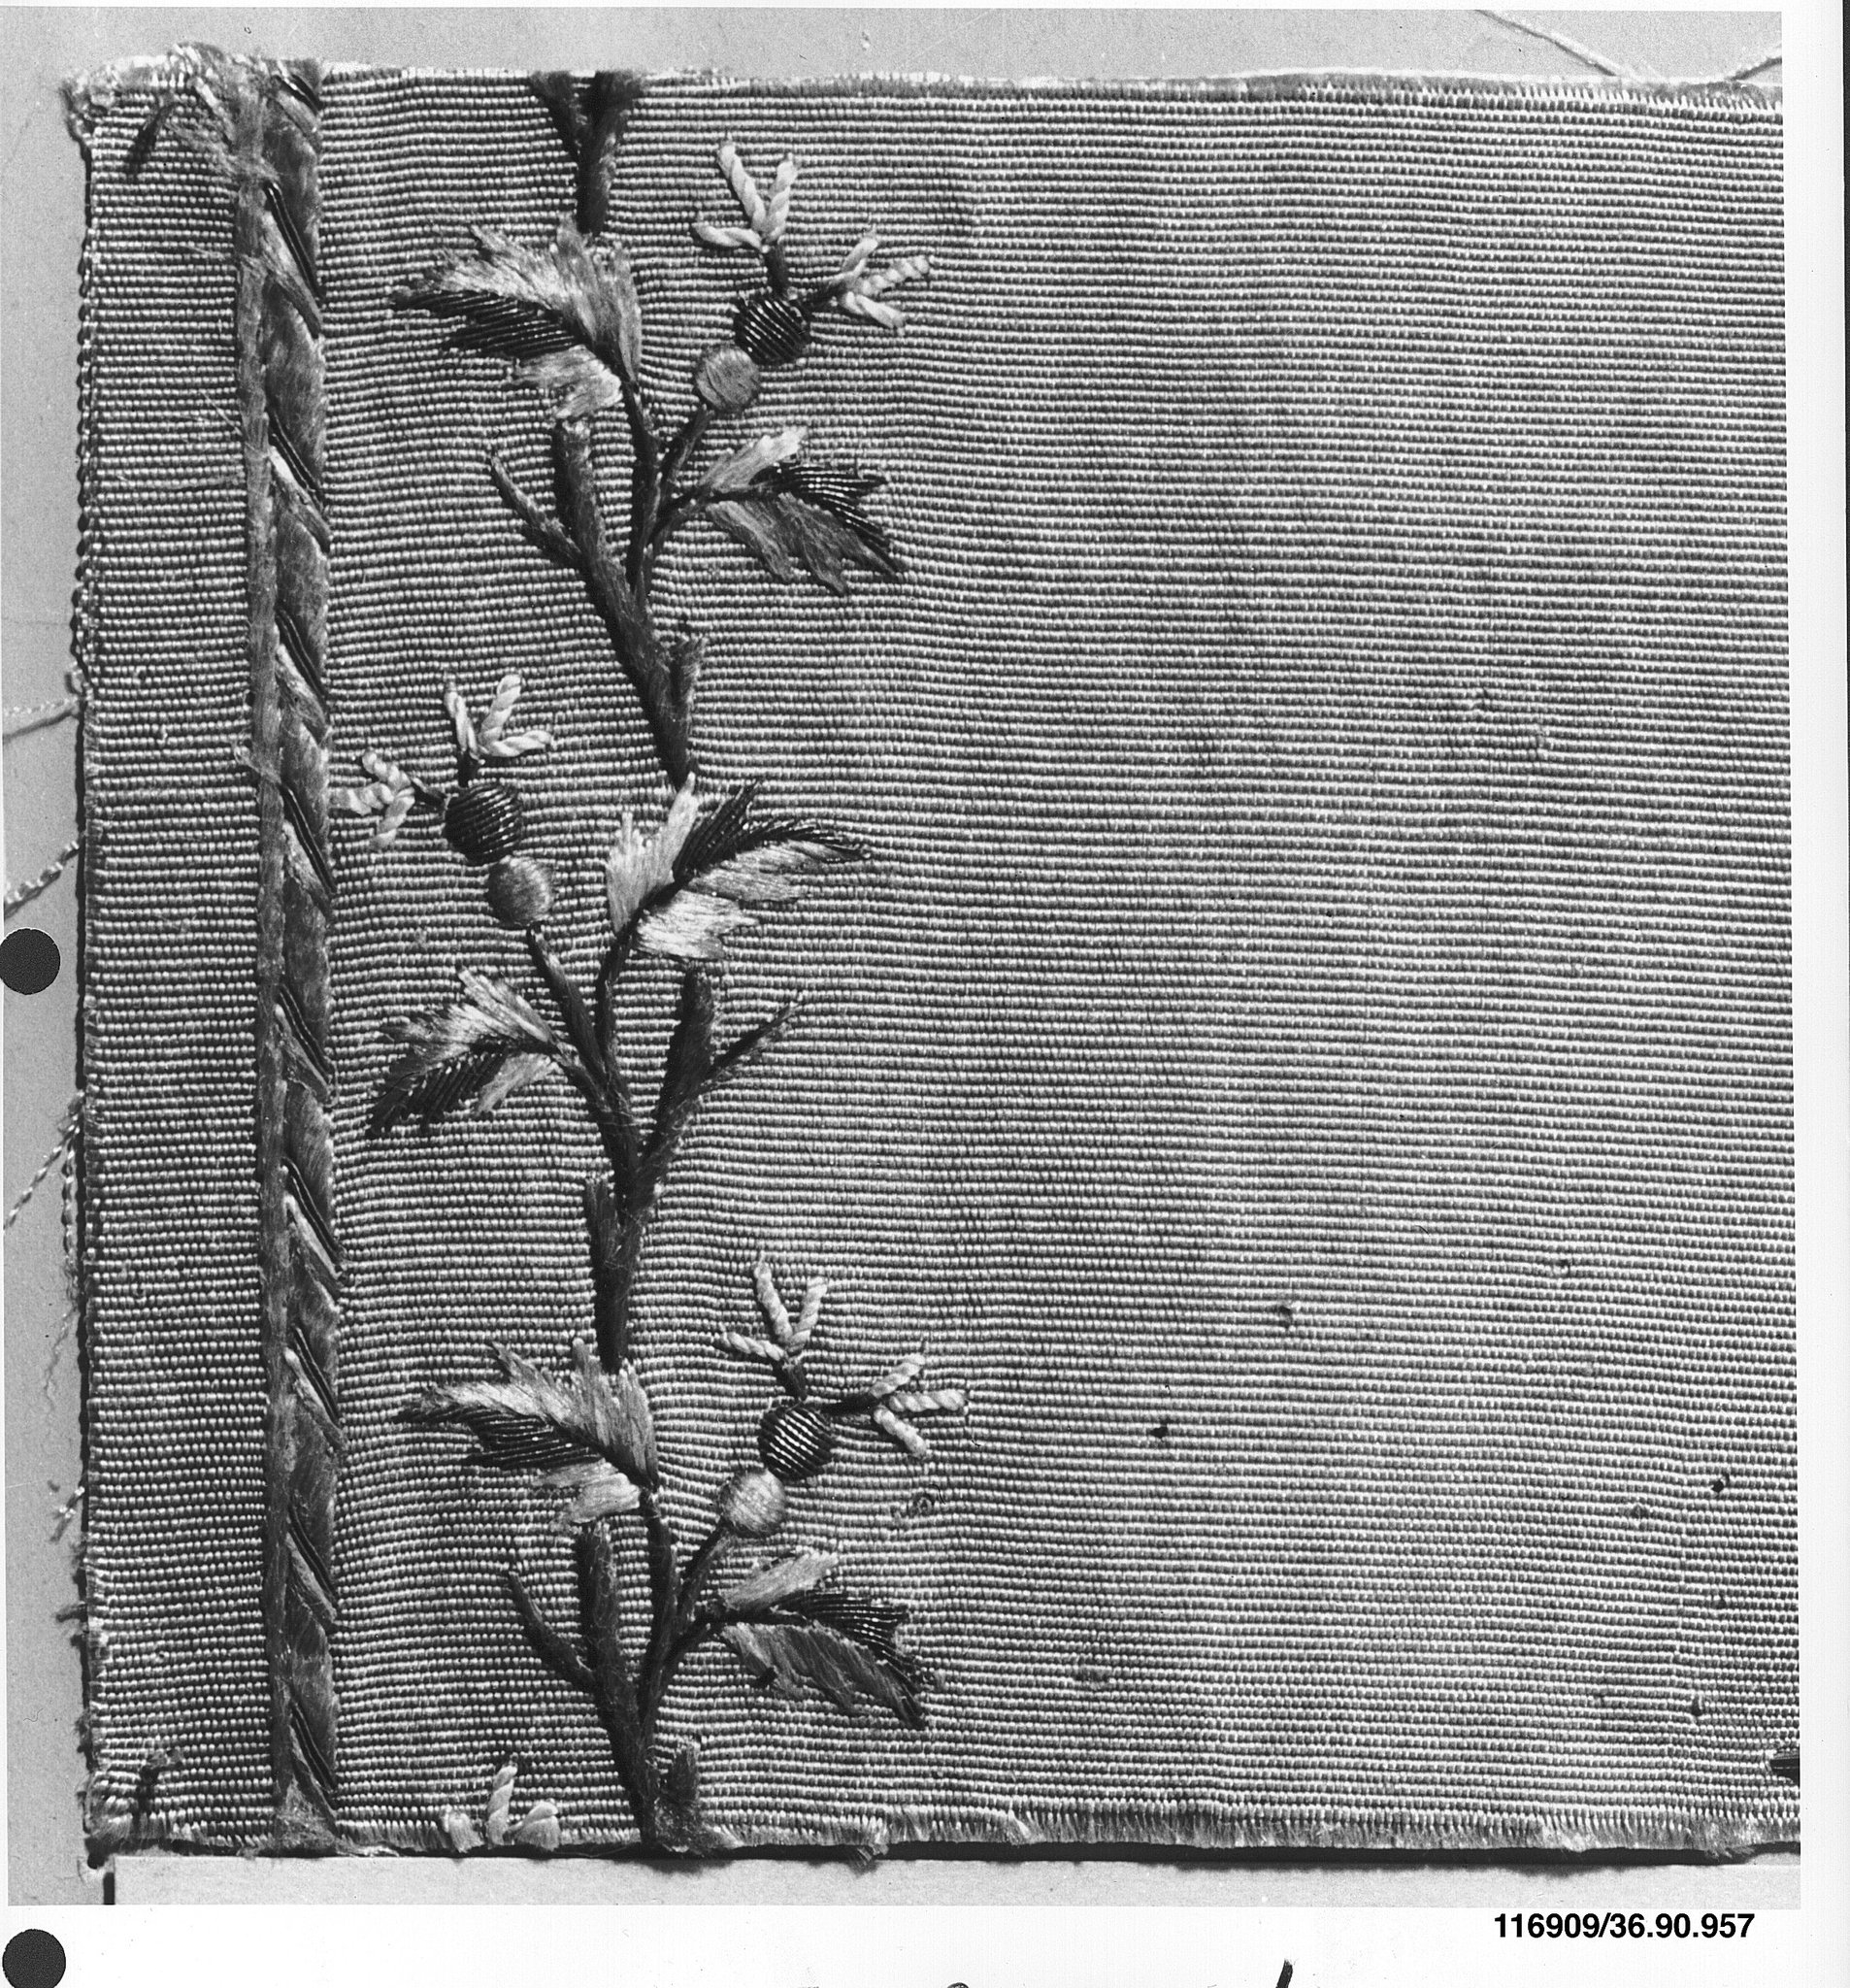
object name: sample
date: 1801-1833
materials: metal thread, silk